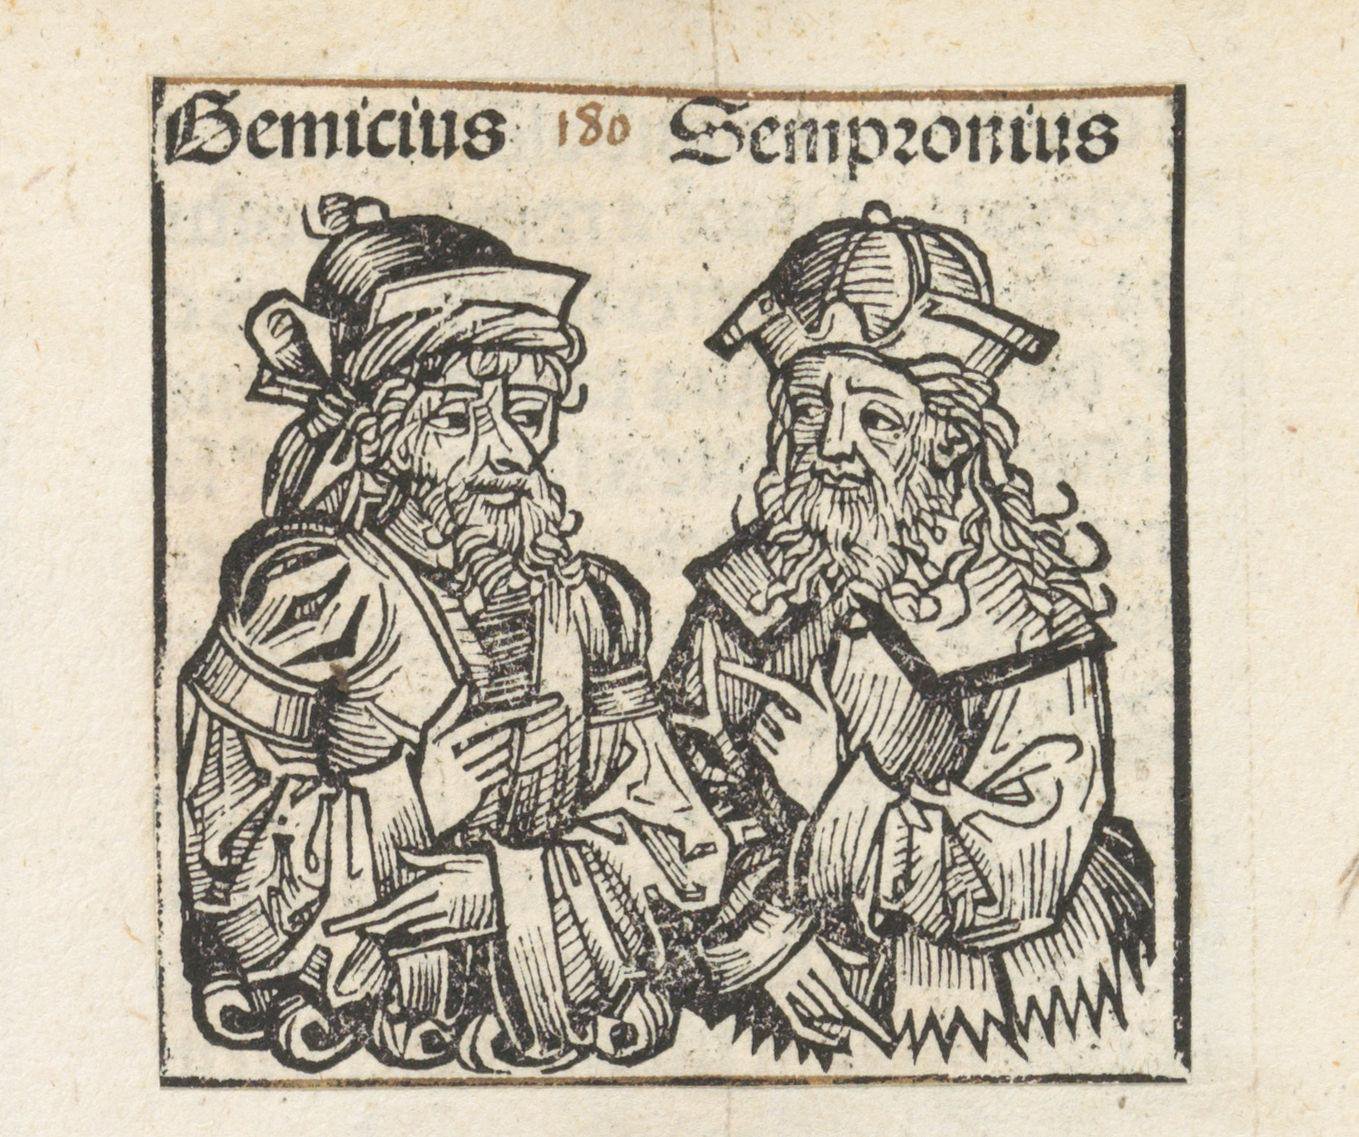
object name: print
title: Gemicius en Sempronius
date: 1493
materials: paper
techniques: letterpress printing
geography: nuremberg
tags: male persons from classical history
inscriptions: inscription: ‘180’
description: Twee bloemkelken met twee mannen. Ze wijzen naar elkaar. De tekst identificeert hen als Gemicius (Genucius?) en Sempronius. De voorstelling is een fragment van de opeenvolging van Romeinse consuls in de Liber Chronicarum. De prent maakt deel uit van een album.